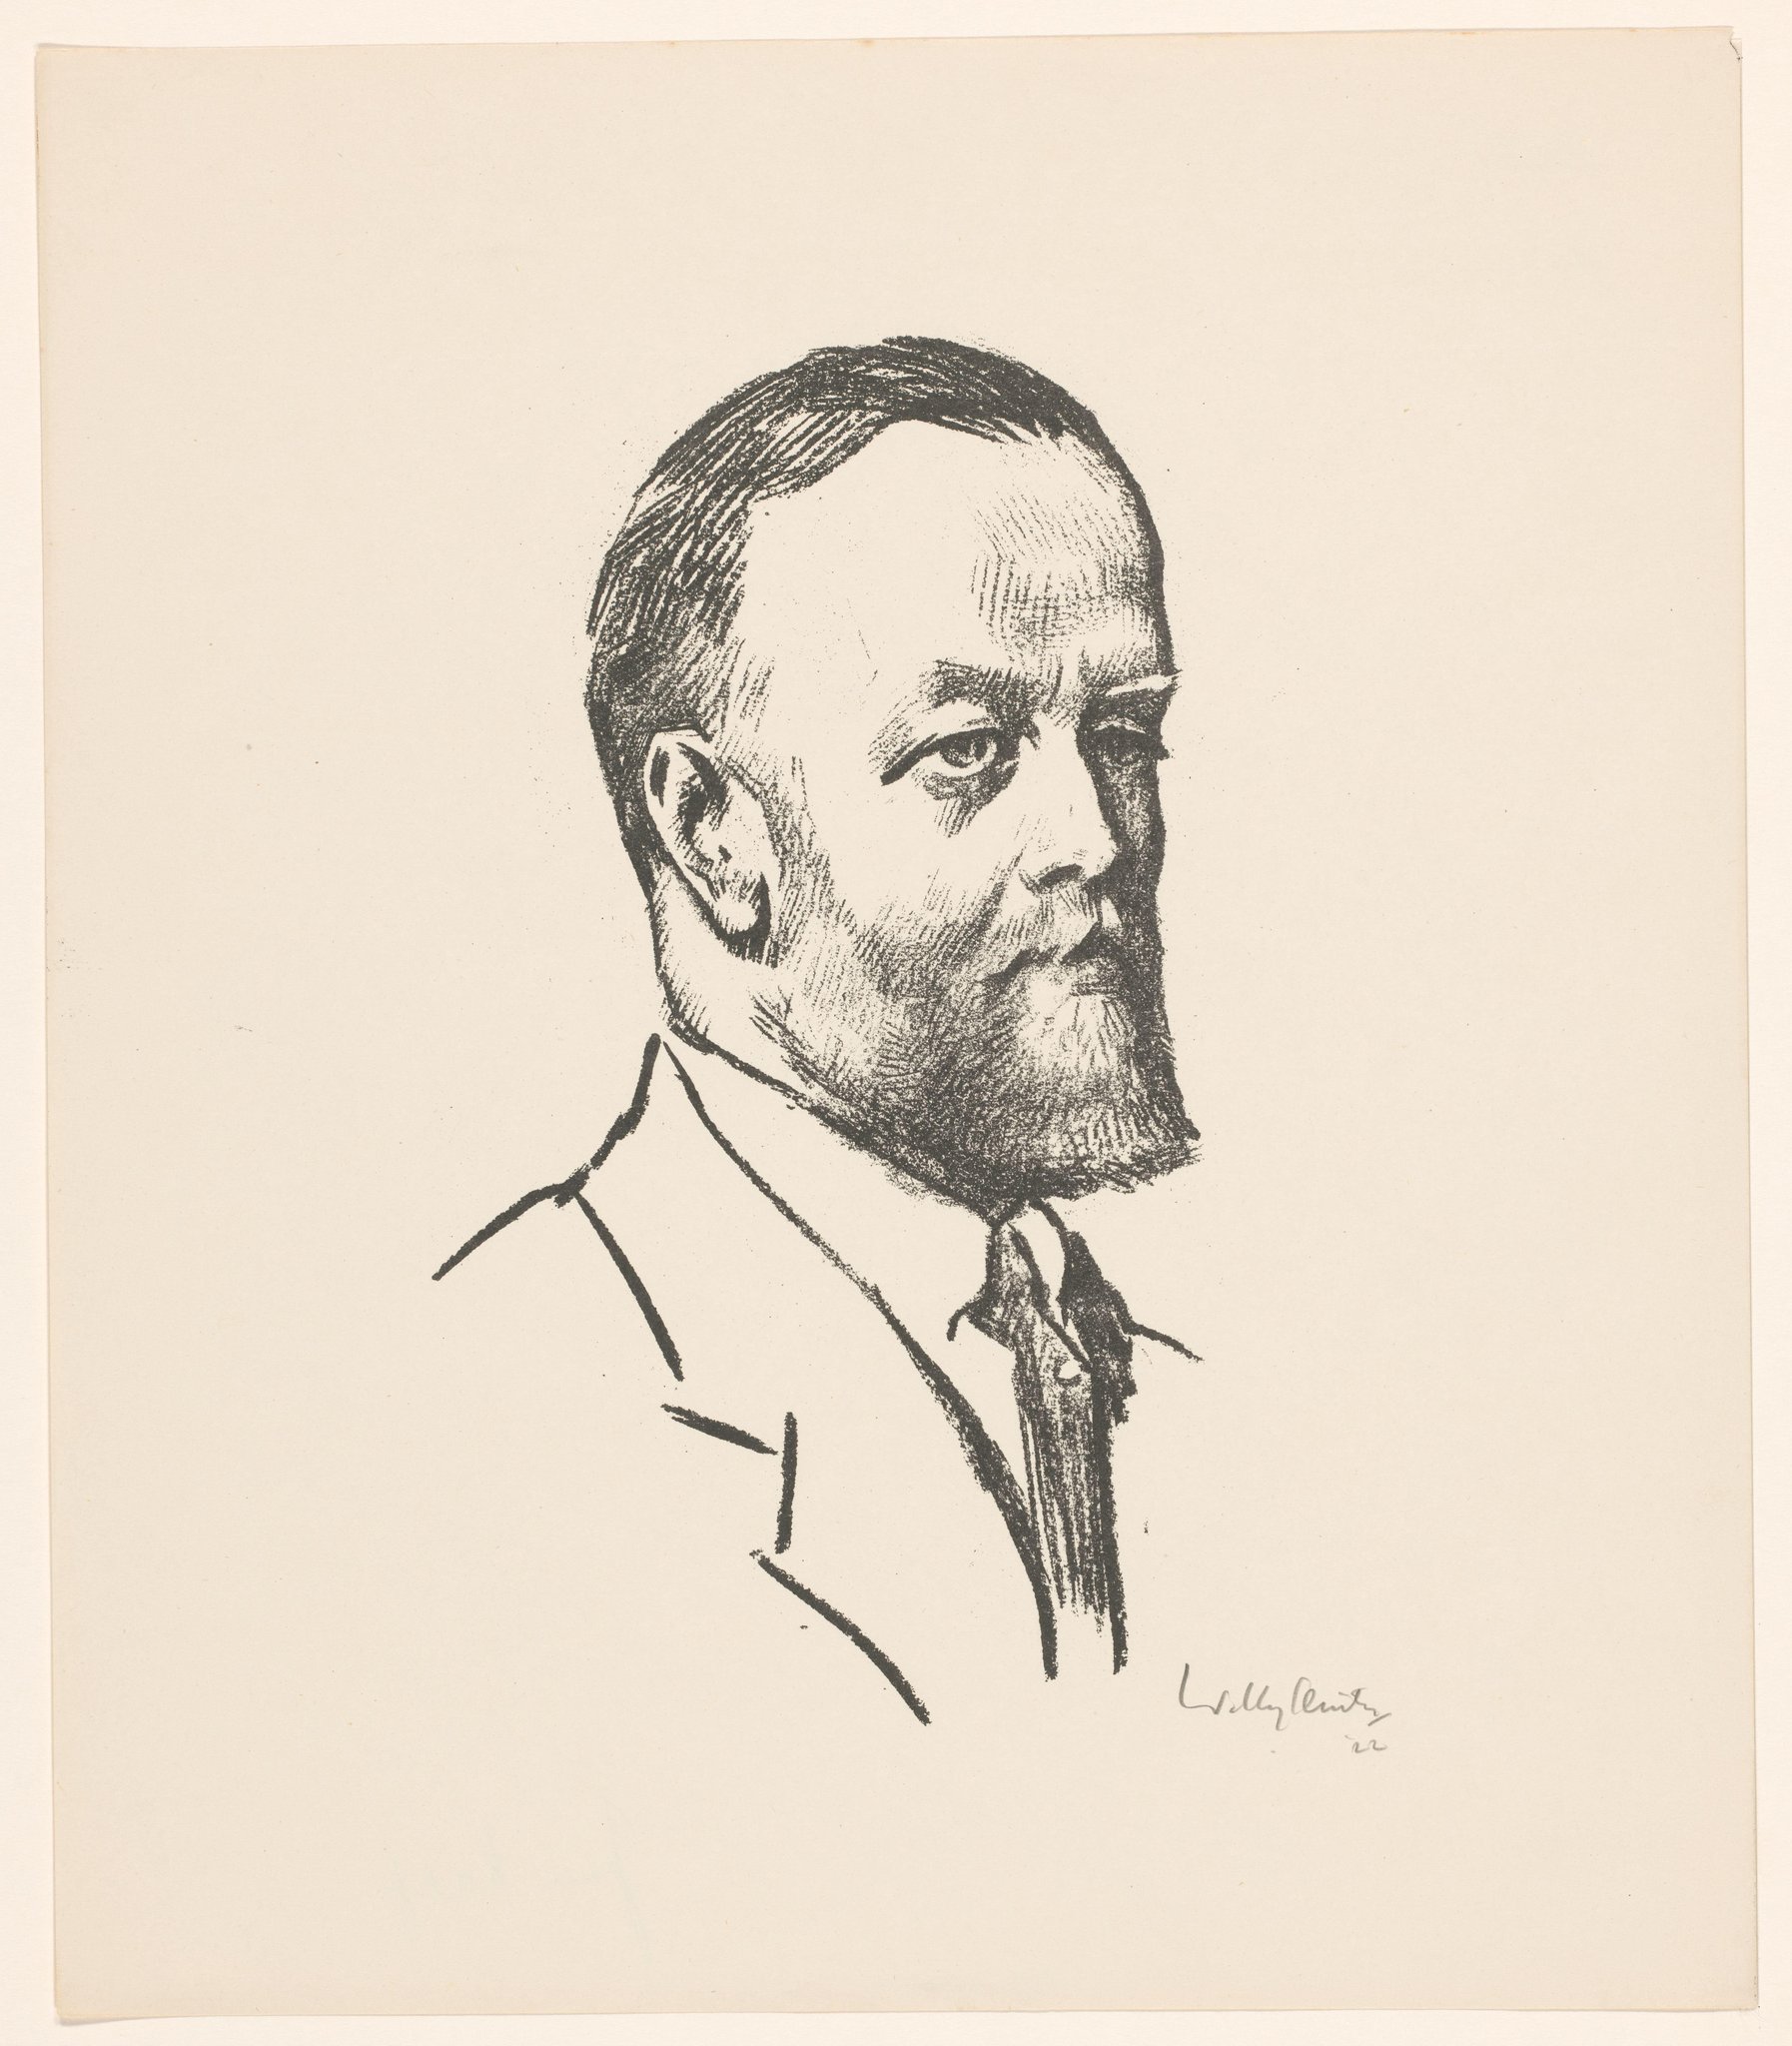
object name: print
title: Portret van Jan Kalf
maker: willy sluiter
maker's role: draughtsman, painter, print maker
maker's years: 1873-1949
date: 1922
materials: paper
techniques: lithograph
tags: amsterdam, jan kalf, historical persons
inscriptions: collector's mark: Lugt 2228